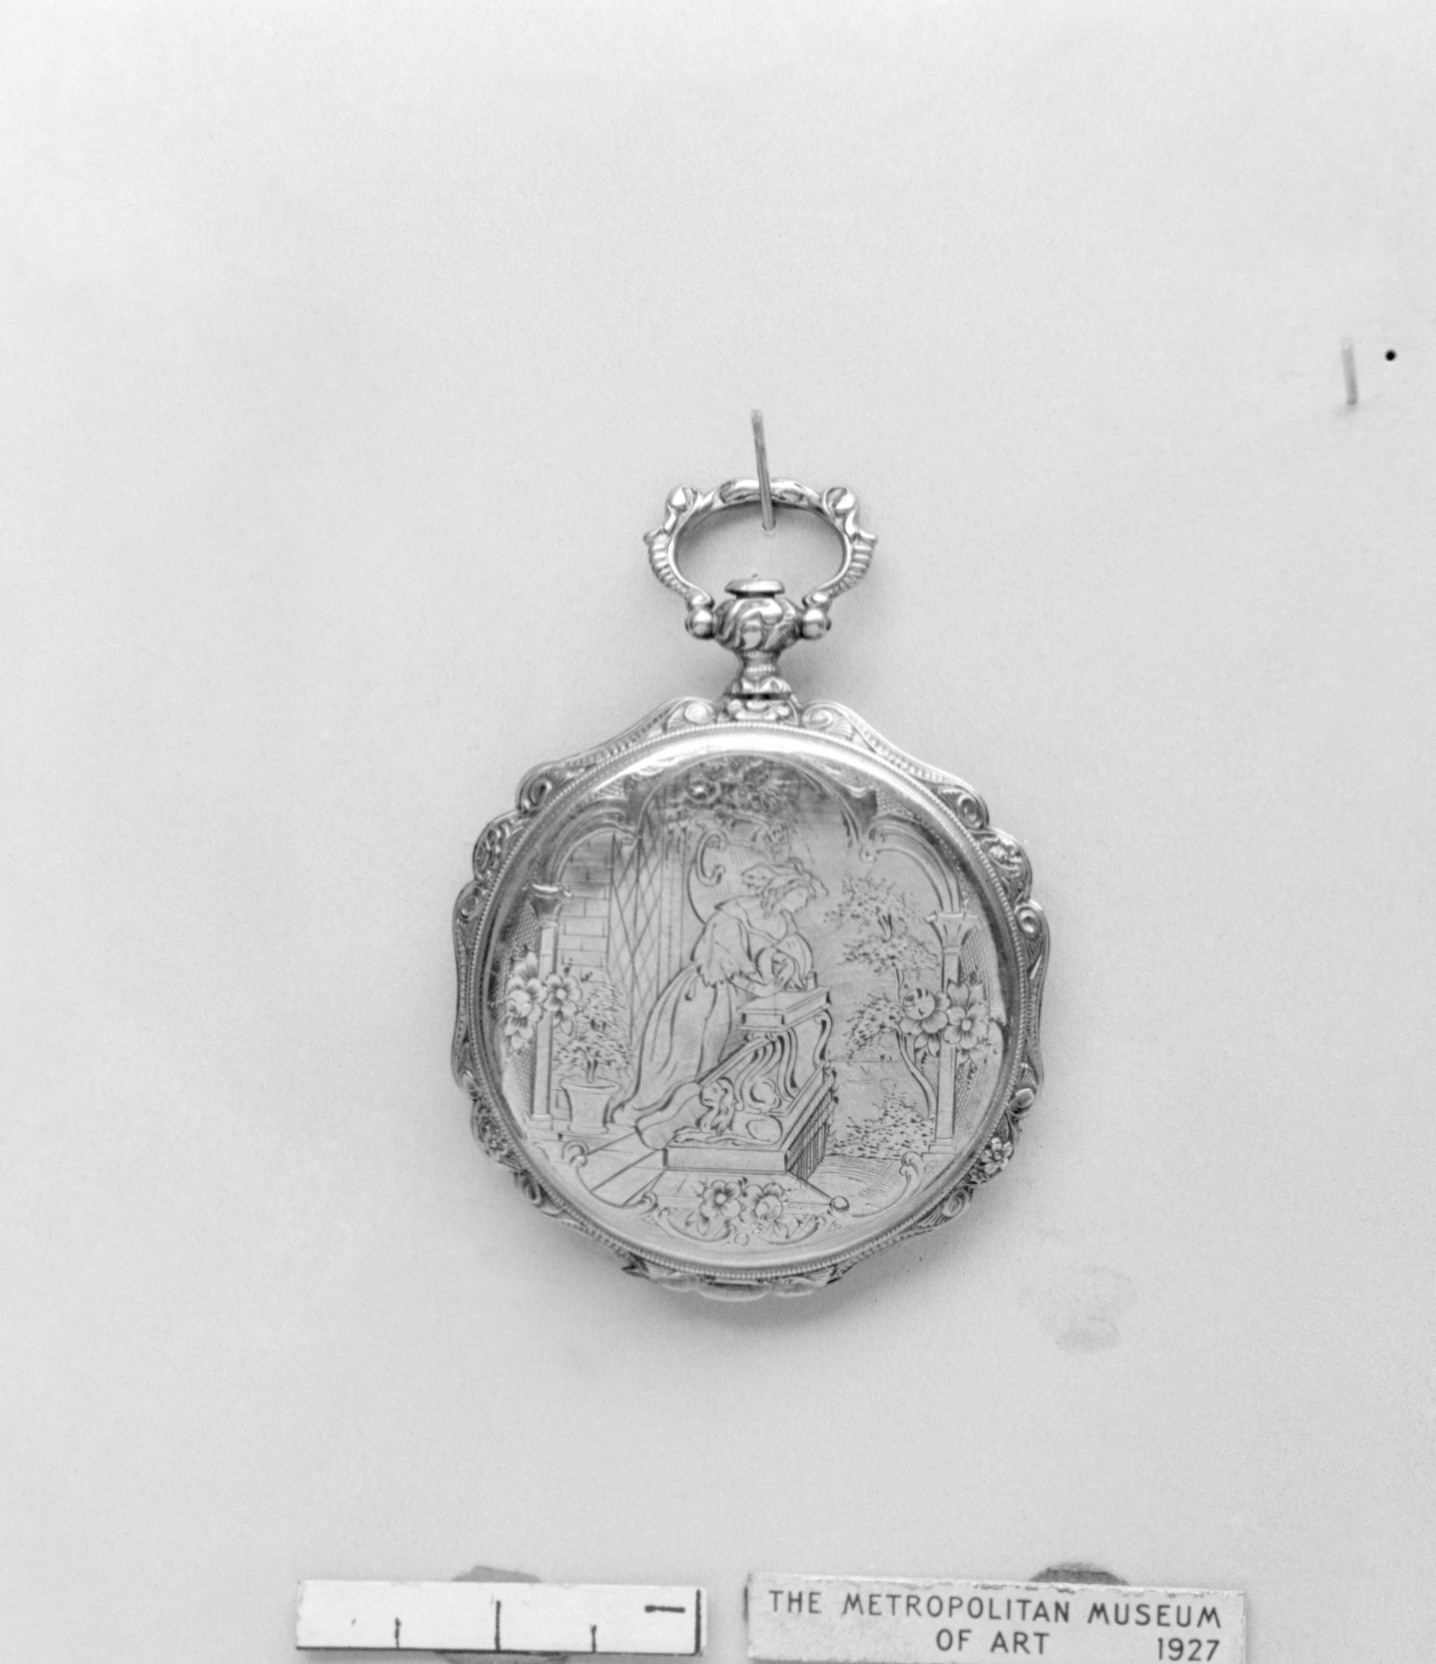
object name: watch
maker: firm of vaucher fréres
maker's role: maker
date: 1830-1840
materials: enamel, gold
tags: women,flowers